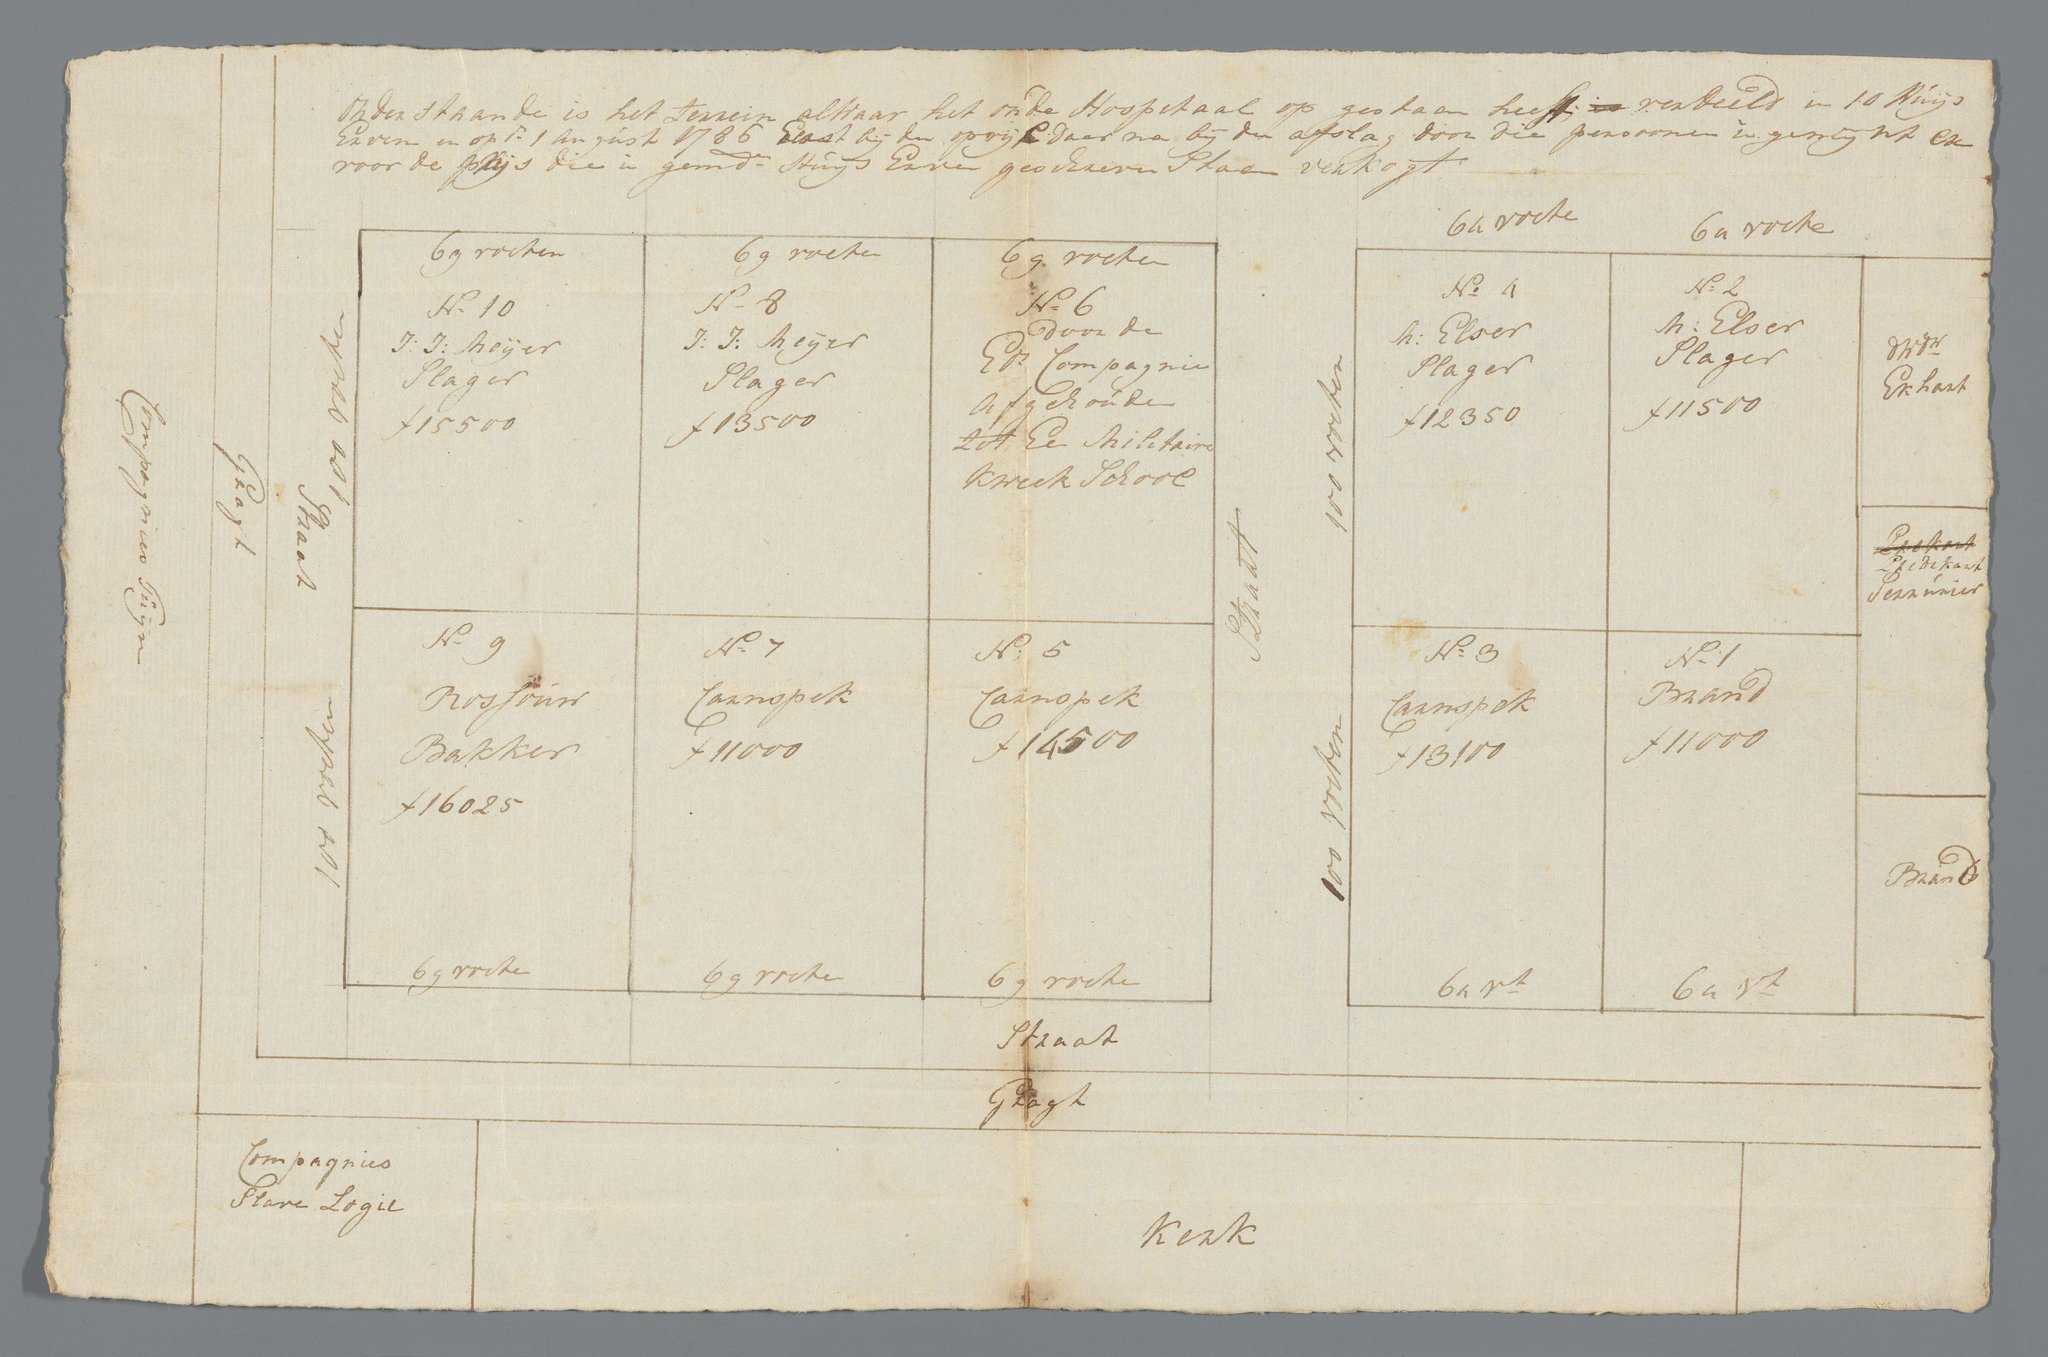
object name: drawing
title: Terrein van het oude Hospitaal in Kaapstad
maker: Anonymous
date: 1708-1786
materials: ink, paper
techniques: pen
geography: south africa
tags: building-site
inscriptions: label: ‘A8’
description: Schematische tekeningen op beide zijden van het blad van het terrein waar het oude Hospitaal in Kaapstad op heeft gestaan, dat in percelen is verdeeld en verkocht, augustus 1786. Op elk perceel de naam van de koper en de betaalde prijs. Het terrein wordt begrensd door de Compagniestuinen, de slavenloge en de kerk.